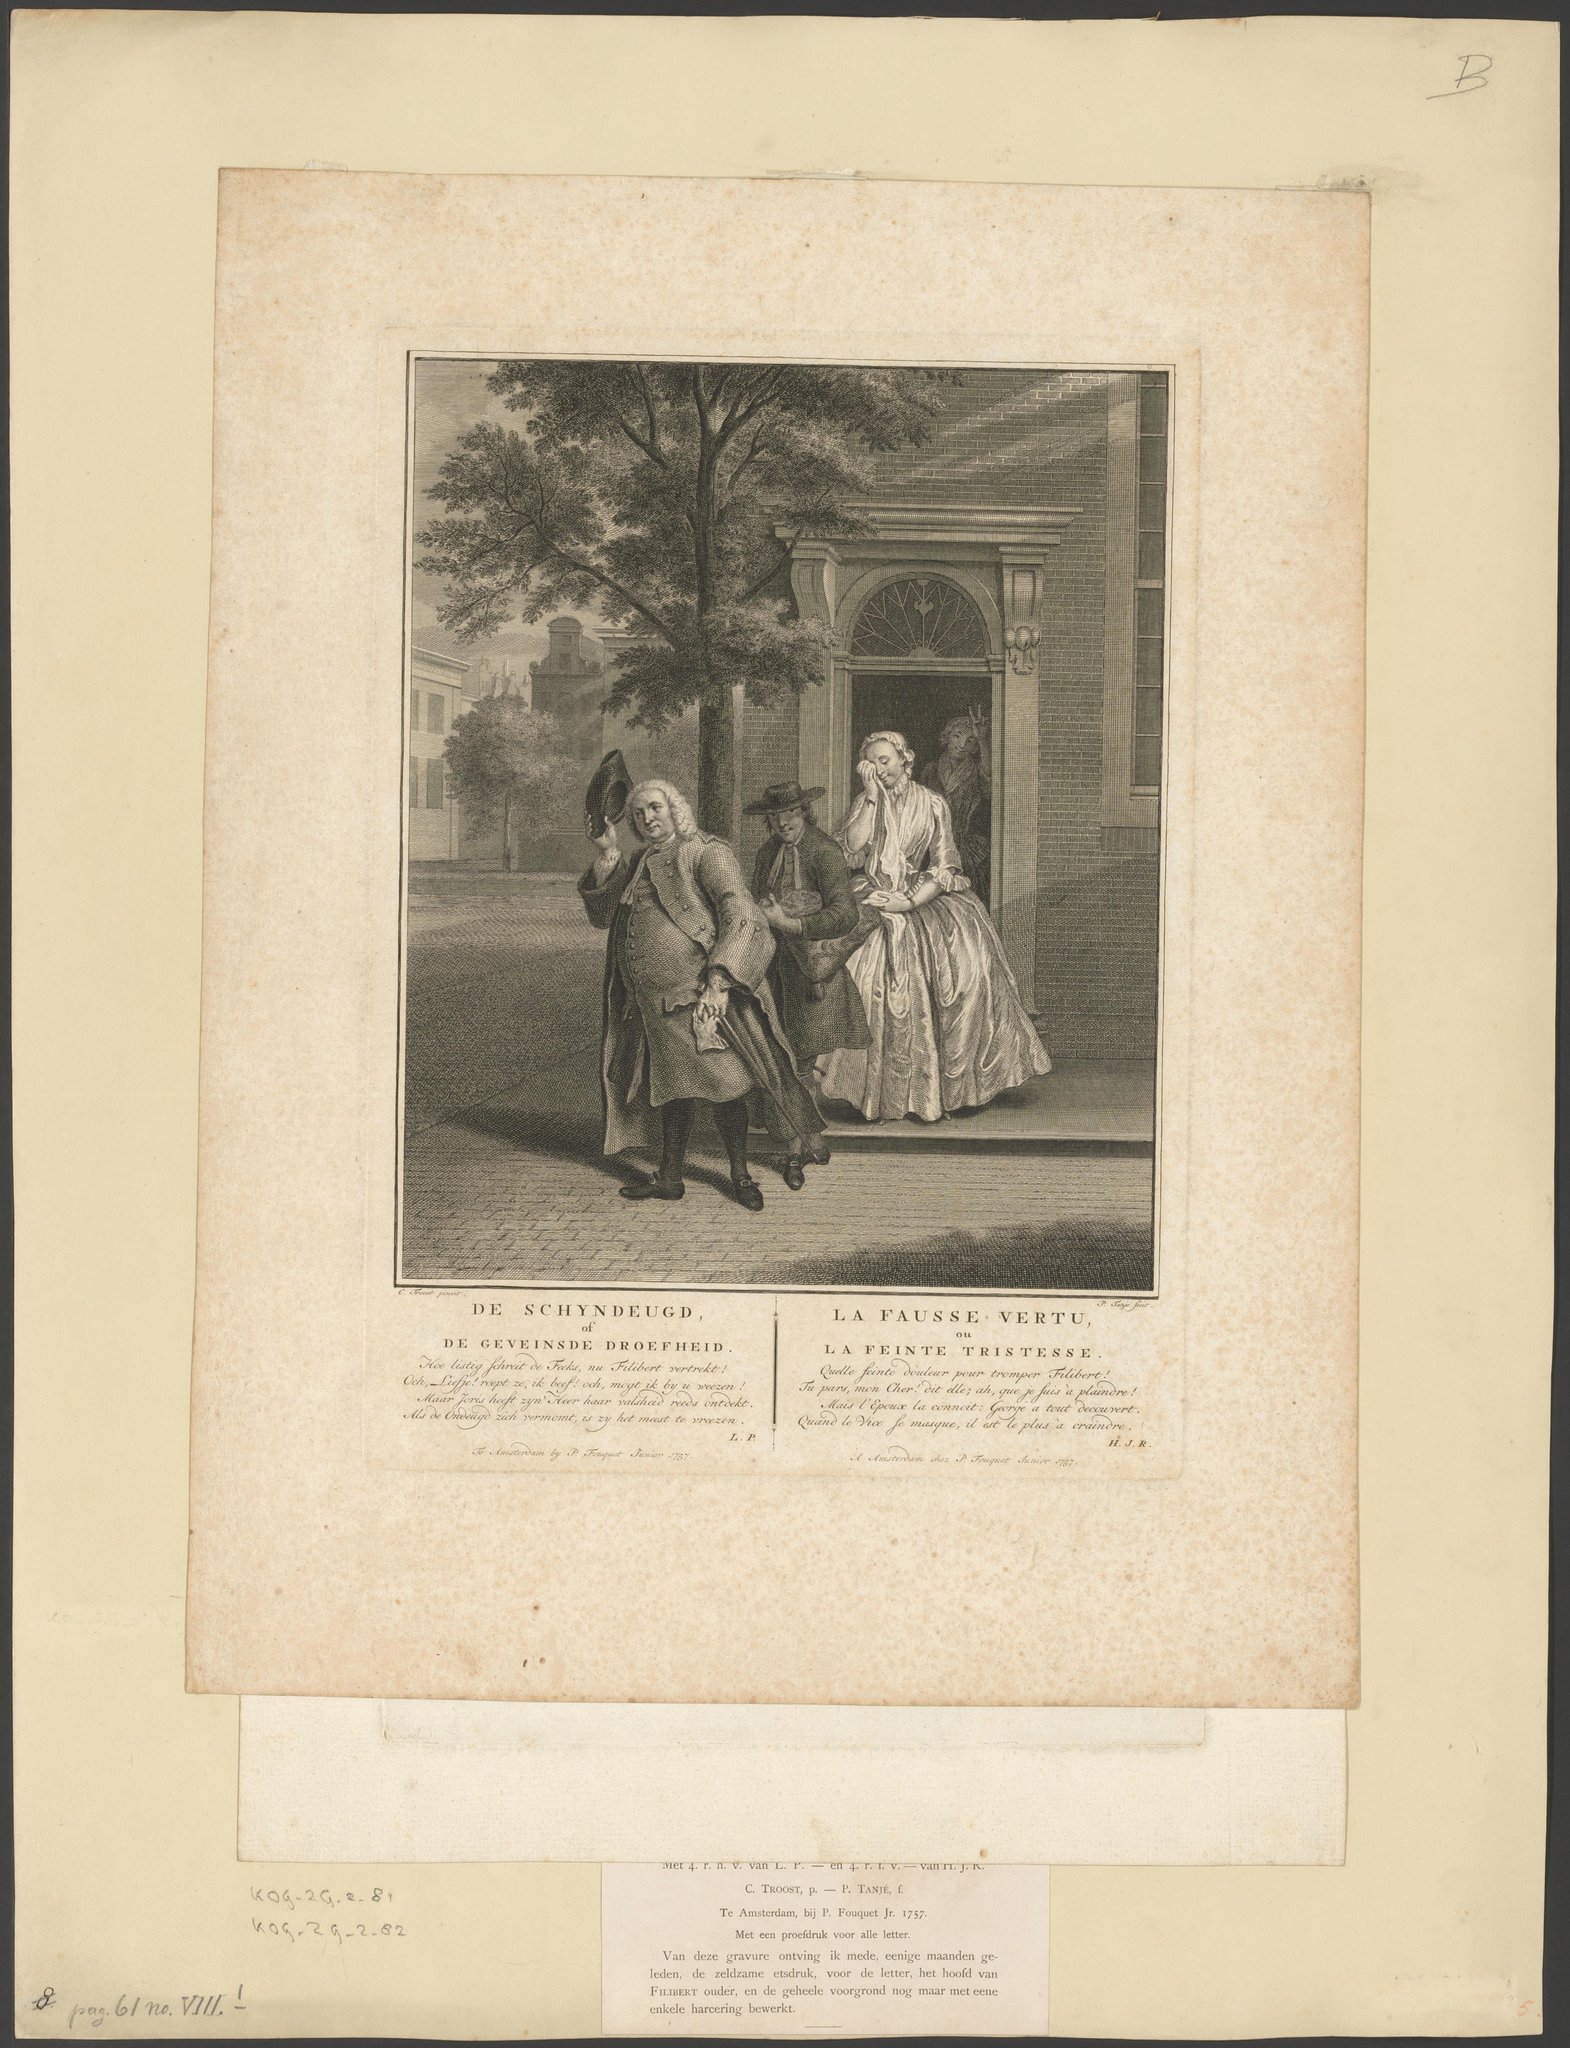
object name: print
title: De Ontdekte Schijndeugd: de geveinsde droefheid van Geertruy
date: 1757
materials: paper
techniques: engraving, etching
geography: amsterdam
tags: partner deceived, hen-pecked husband, weeping, comedy, postures and gestures of index finger and middle finger, waving farewell ~ departure on a journey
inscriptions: collector's mark: Lugt 2488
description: Geertruy veinst verdriet als ze haar man Filibert, die op zakenreis gaat, gedag zegt. Filibert heeft zojuist van zijn knecht Joris, die achter hem loopt, vernomen dat Geertruy hem met zijn neef bedriegt. De dienstmeid Bely bespot Filibert als bedrogen echtgenoot door twee vingers als horentjes bij haar hoofd te houden. Onderaan in de marge twee vierregelige verzen in het Nederlands en het Frans. Scène uit het toneelstuk De Ontdekte Schijndeugd, van David Lingelbach.